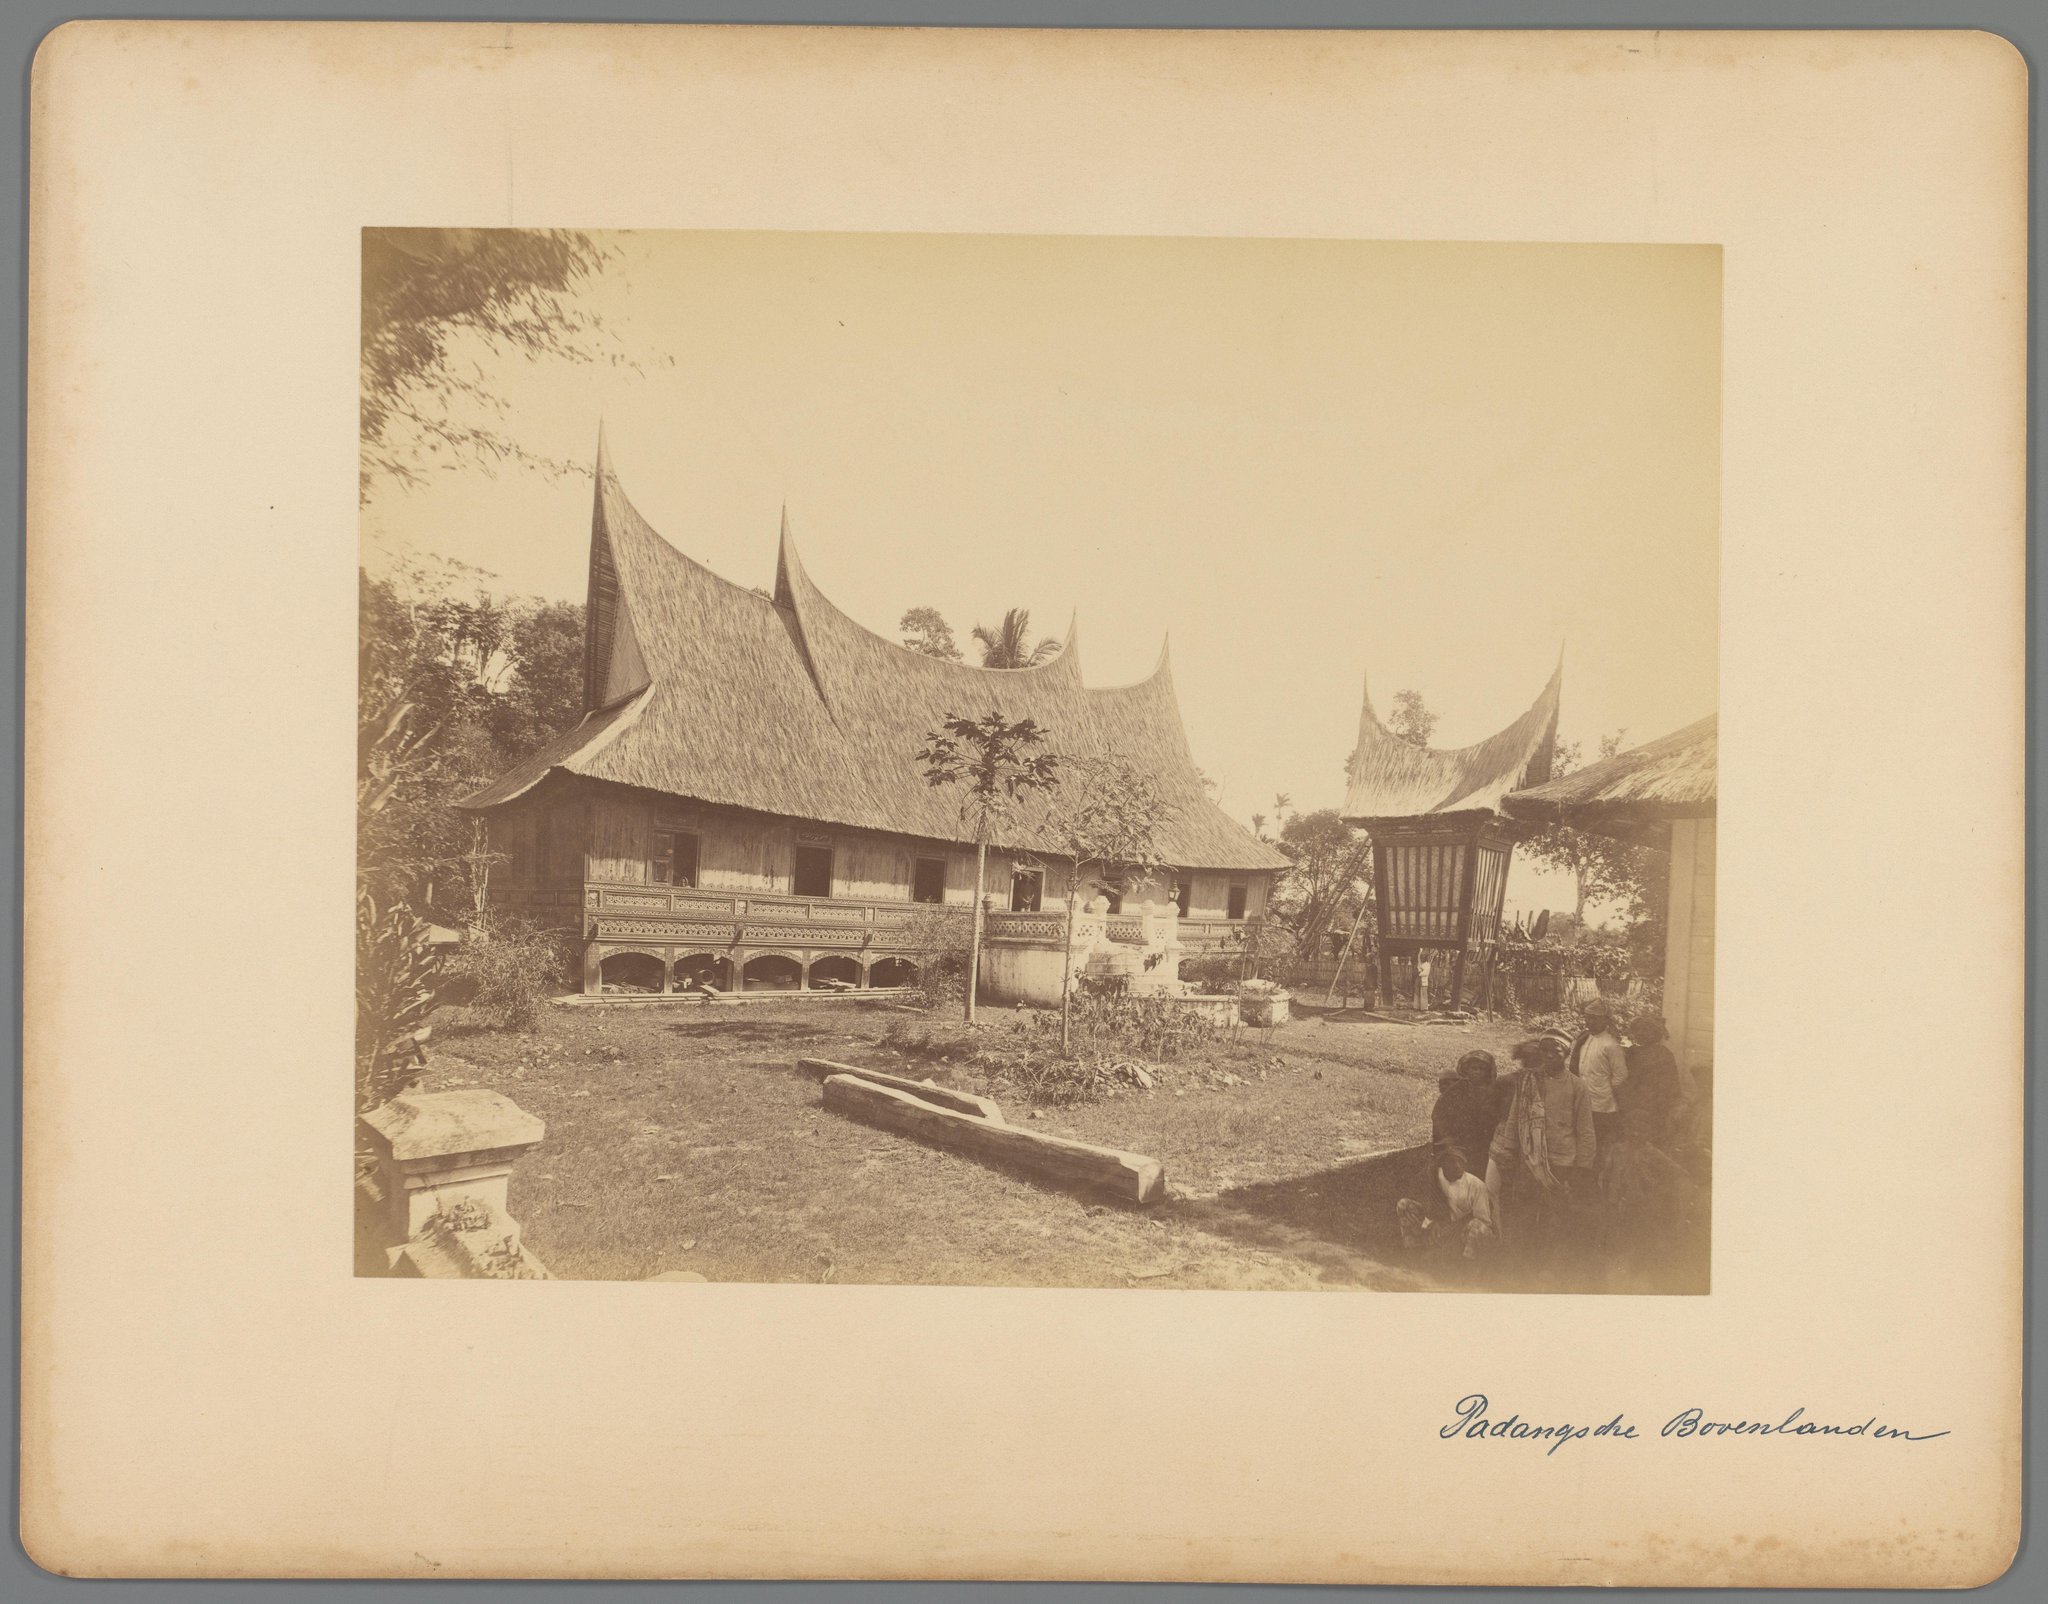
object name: photograph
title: Huizen in een dorp nabij Bukittinggi, West-Sumatra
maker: christiaan benjamin nieuwenhuis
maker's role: publisher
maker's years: 1863-1922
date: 1891-1895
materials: cardboard, paper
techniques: albumen print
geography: sumatera barat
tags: village, sumatera barat (province)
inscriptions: inscription: ‘Foto’, inscription: ‘Fort de Kock’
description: Deze foto zat oorspronkelijk in prentenkabinet RP-F-AA3192.